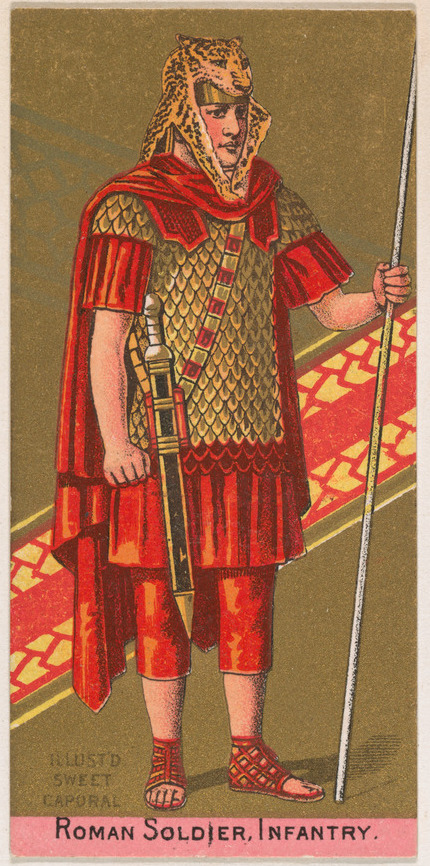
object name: print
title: Roman Soldier, Infantry, from the Military Series (N224) issued by Kinney Tobacco Company to promote Sweet Caporal Cigarettes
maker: kinney brothers tobacco company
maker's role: publisher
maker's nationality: american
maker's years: 1869-2011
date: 1888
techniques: color lithograph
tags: military,men